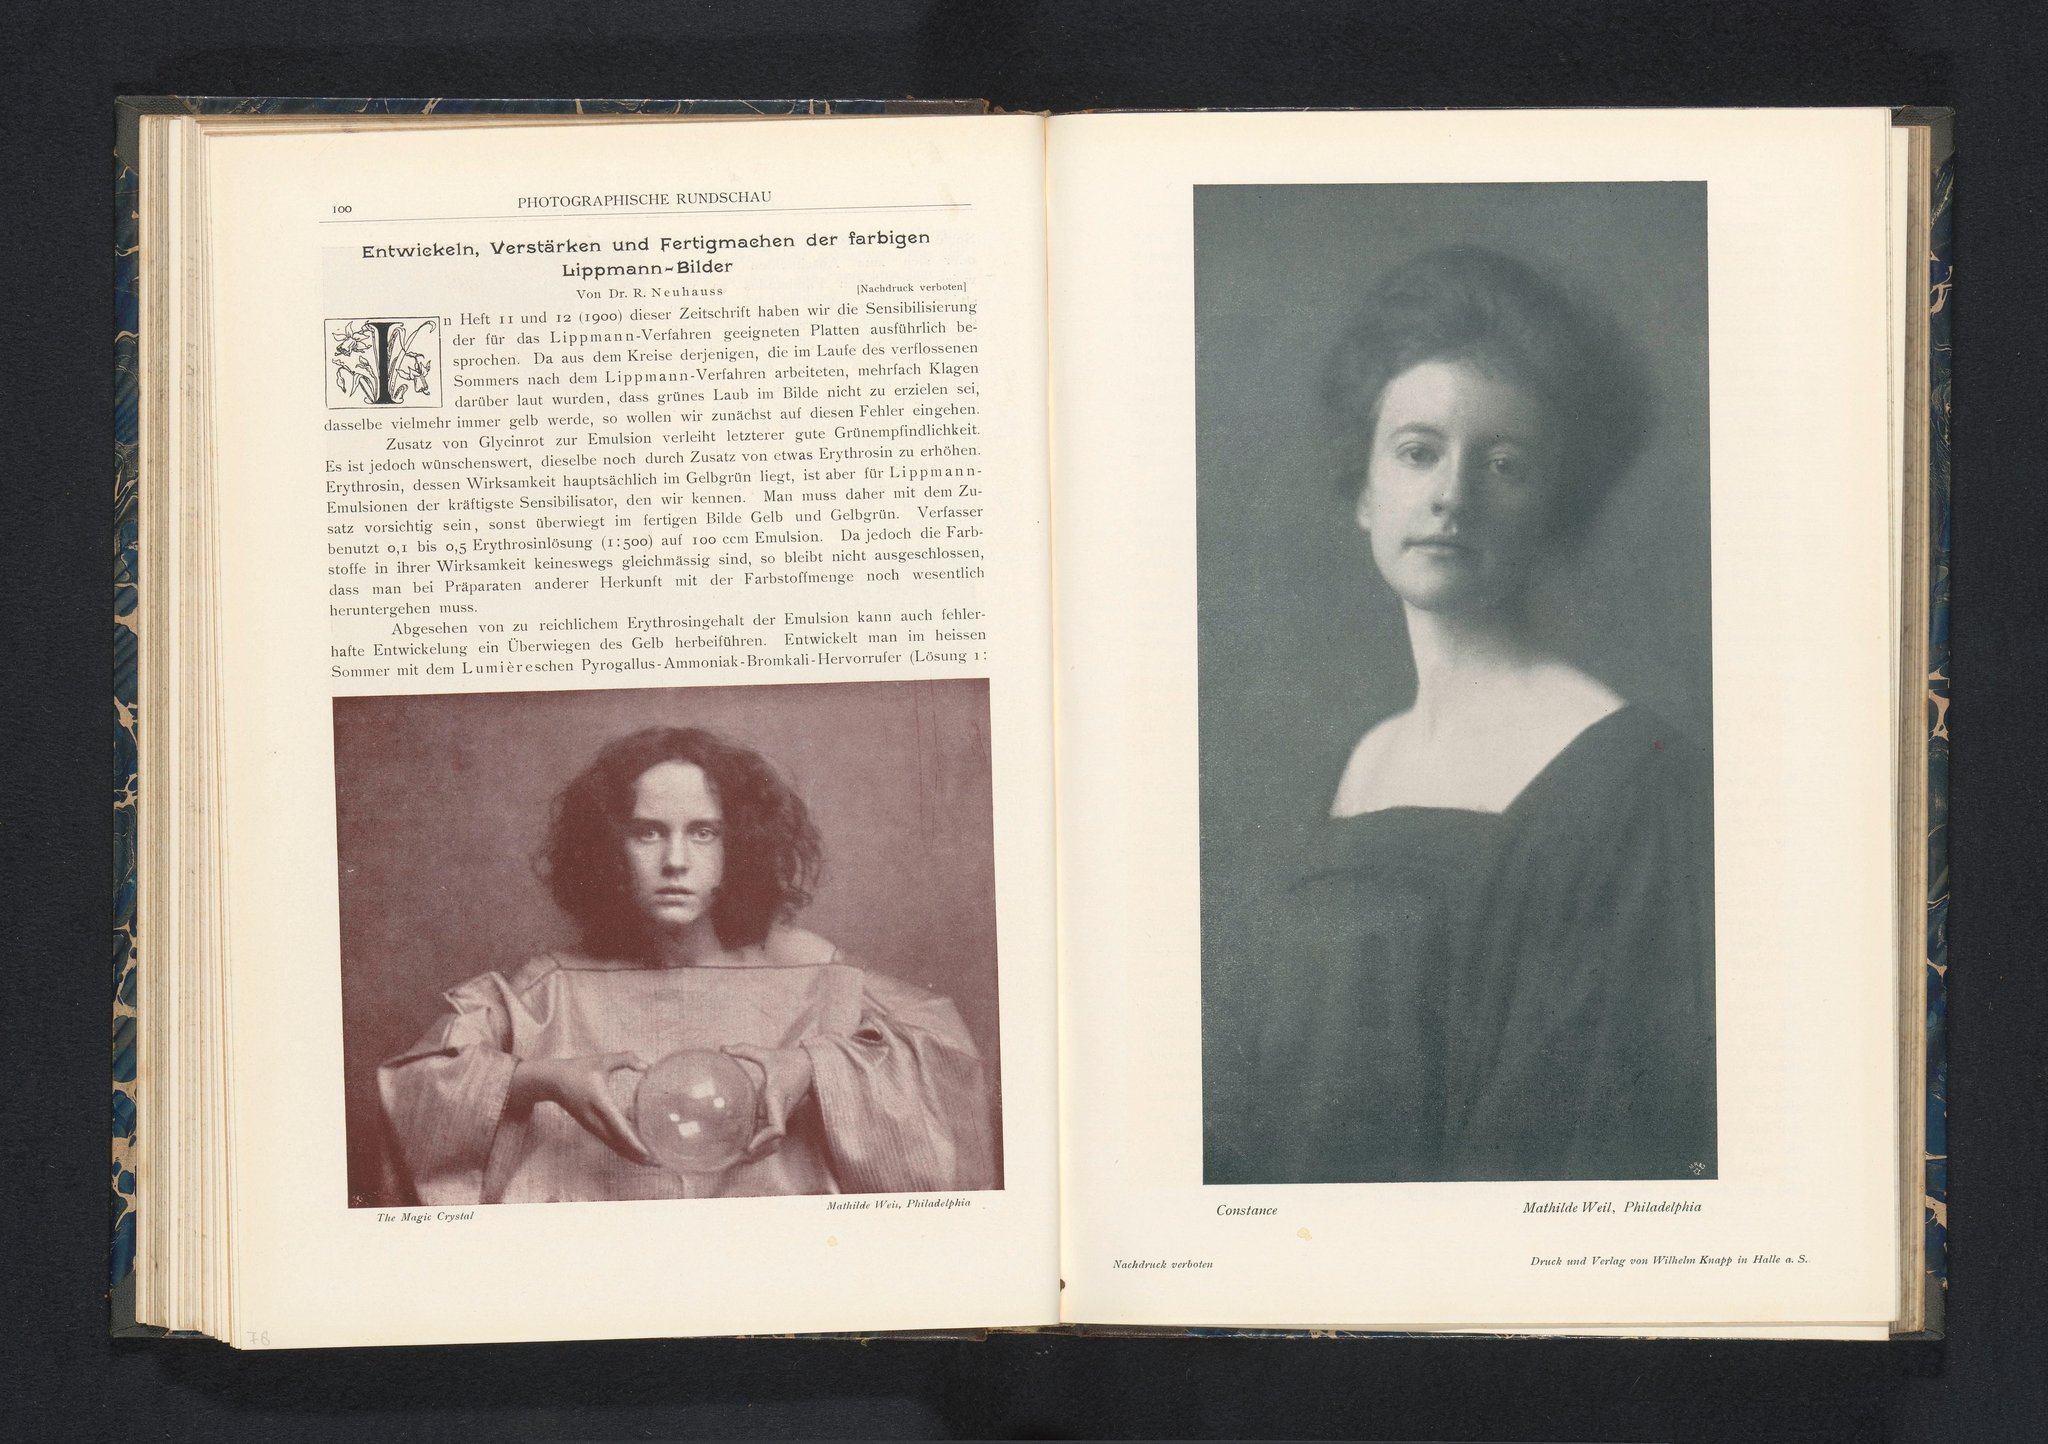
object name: photomechanical print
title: The Magic Crystal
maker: mathilde weil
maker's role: fotograaf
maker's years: 1872-1918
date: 1896-1901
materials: paper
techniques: autotype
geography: berlin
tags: historical persons not known by name - bb - woman